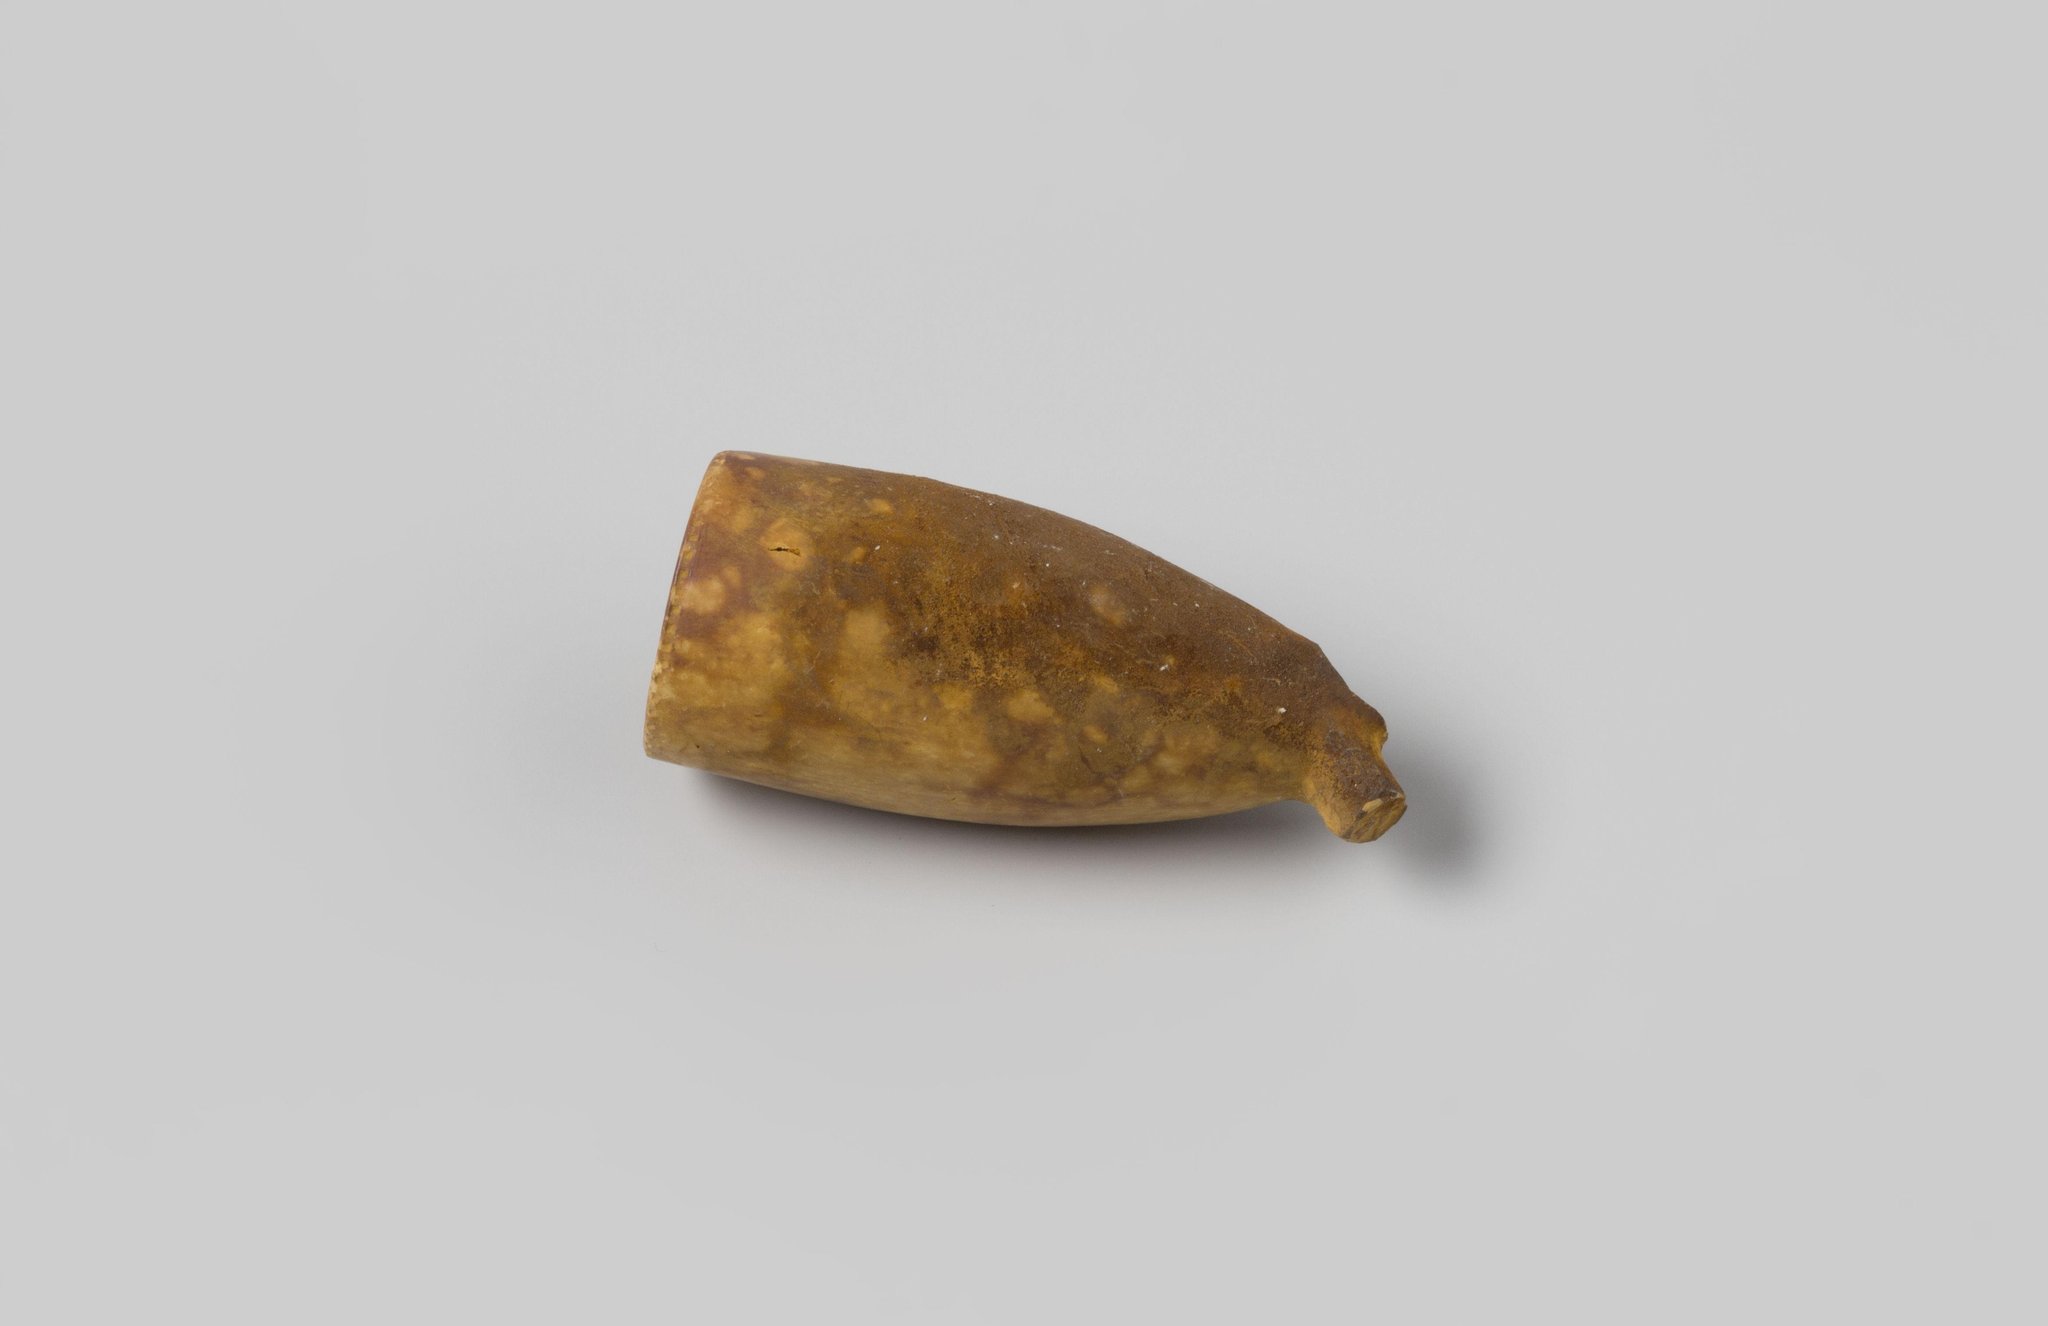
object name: pipe bowl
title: Pijpenkop uit het wrak van de Oost-Indiëvaarder Hollandia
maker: Anonymous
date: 1700-1743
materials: clay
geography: netherlands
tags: verenigde oostindische compagnie, hollandia (schip), annet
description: Pipe, bowl, heelmark: tobacco's brazier; 2hsm1,3.